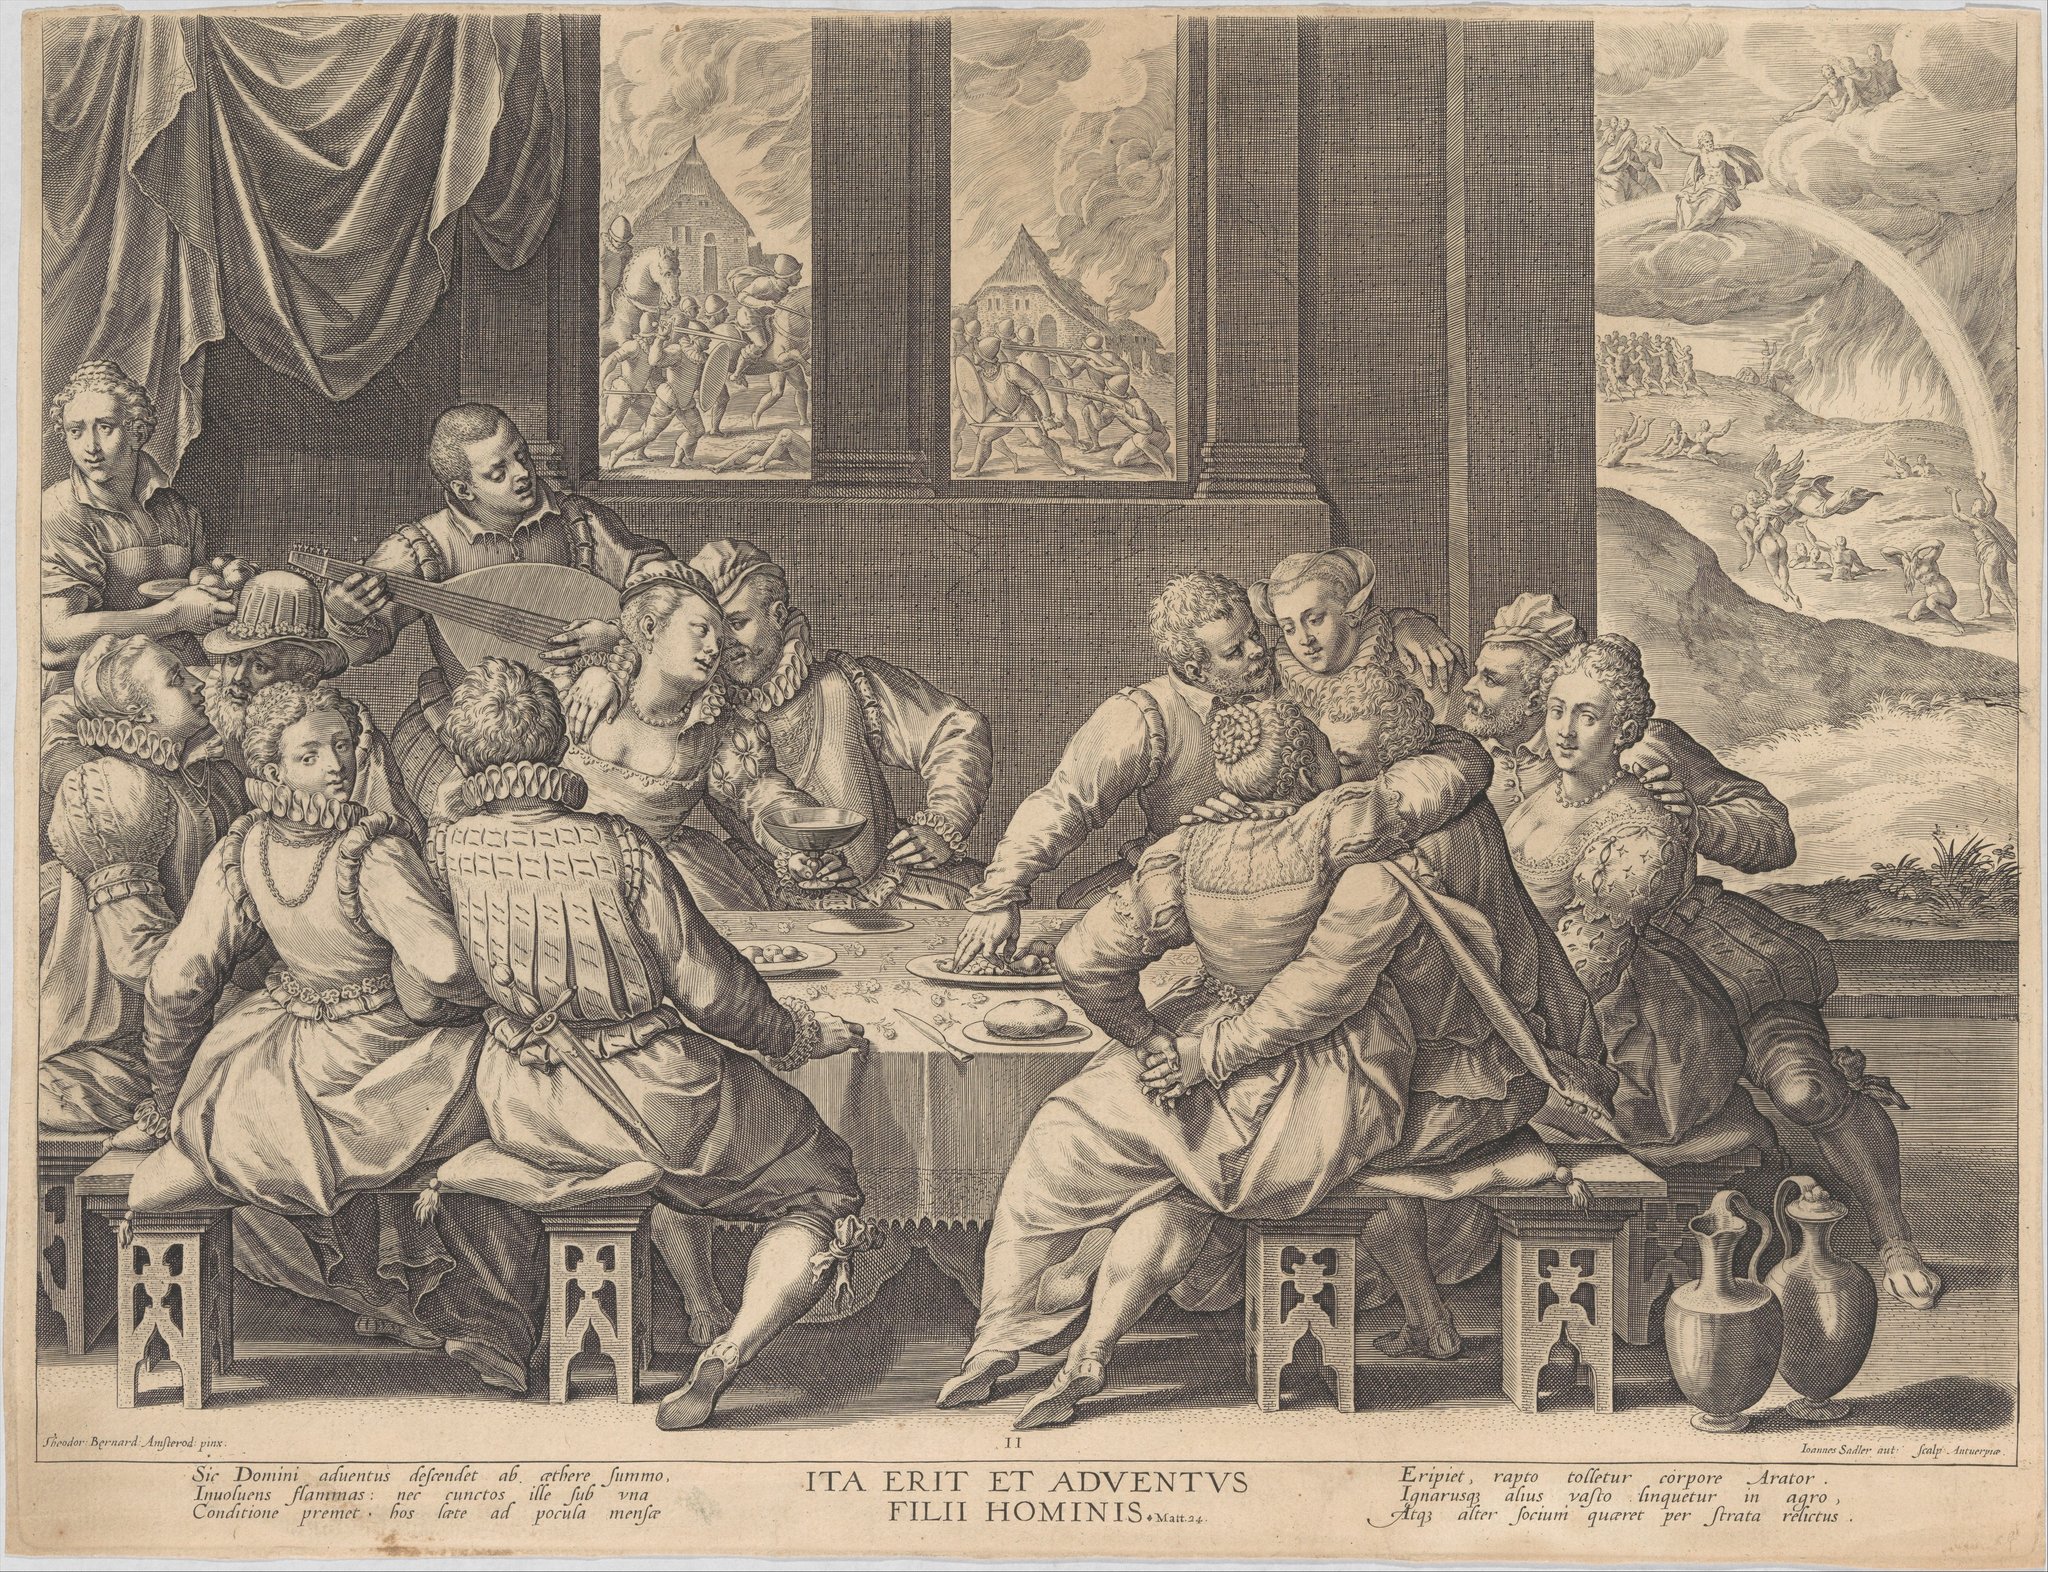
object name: print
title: Mankind Awaiting the Last Judgement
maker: johann sadeler (i)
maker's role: artist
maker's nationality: netherlandish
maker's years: 1550-1601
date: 1568-1600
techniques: engraving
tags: food,men,women,dining,musicians